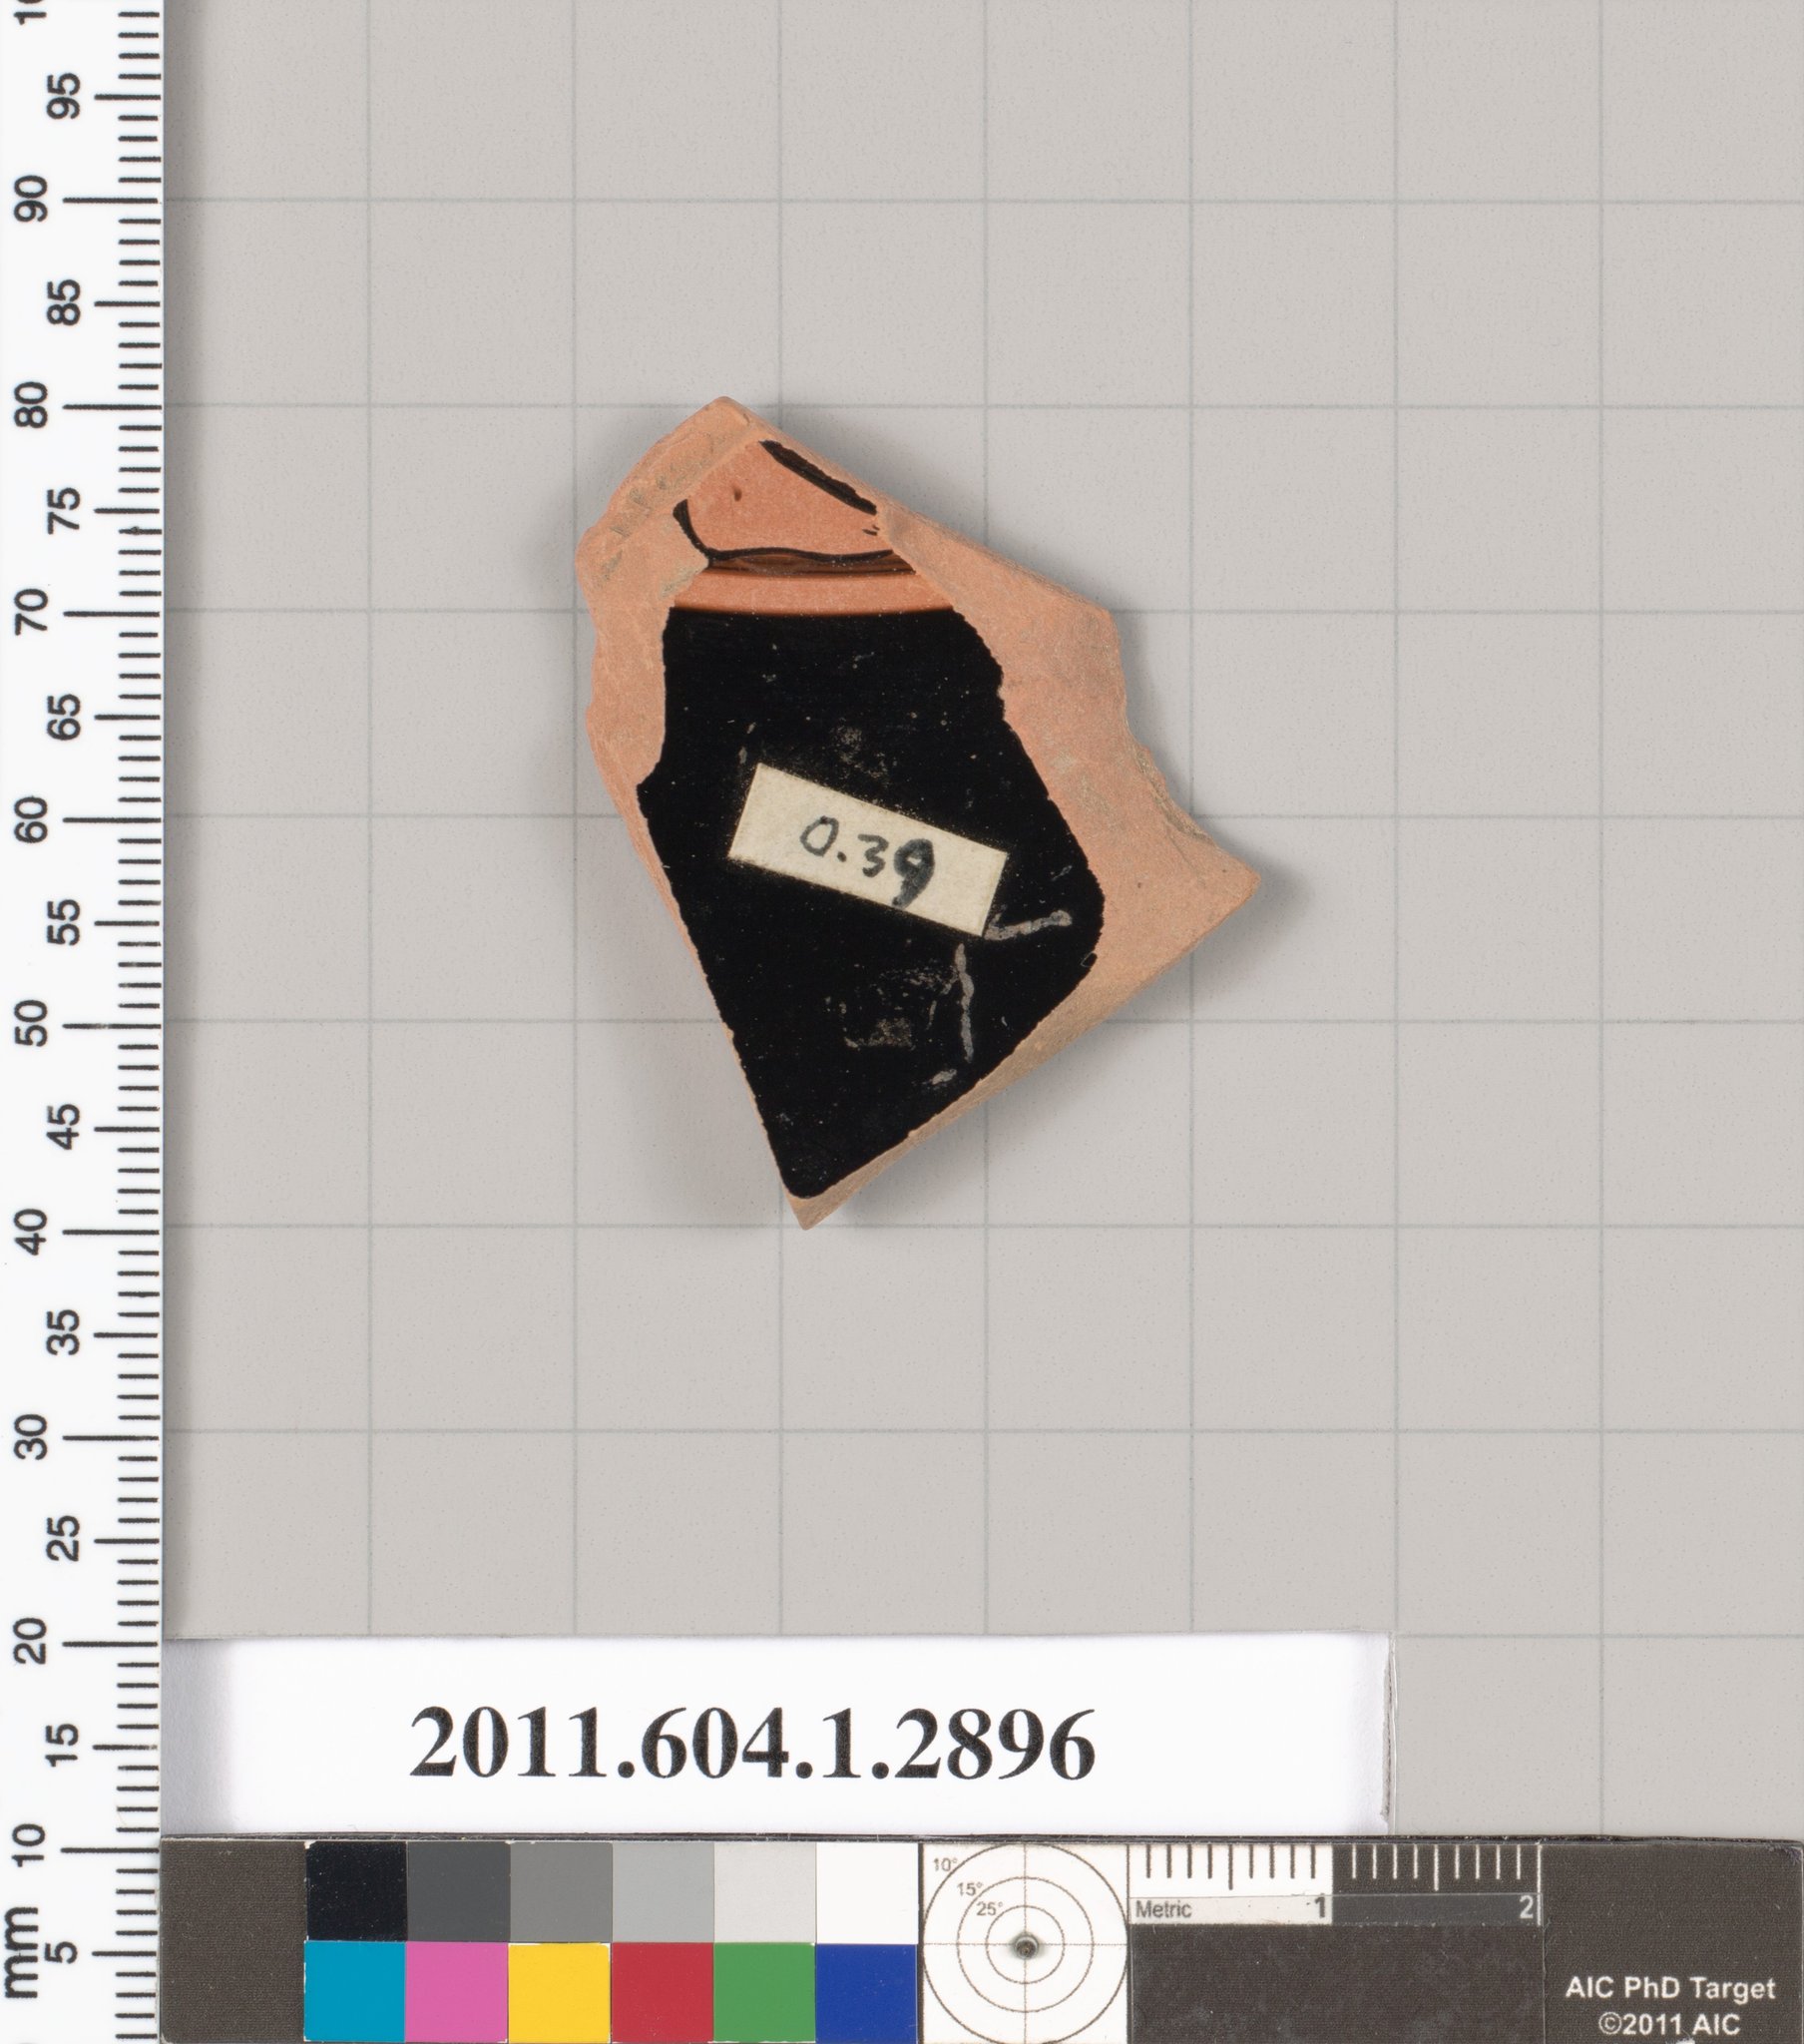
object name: kylix fragment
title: Terracotta fragment of a kylix (drinking cup)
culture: greek, attic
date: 520-490 BCE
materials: terracotta